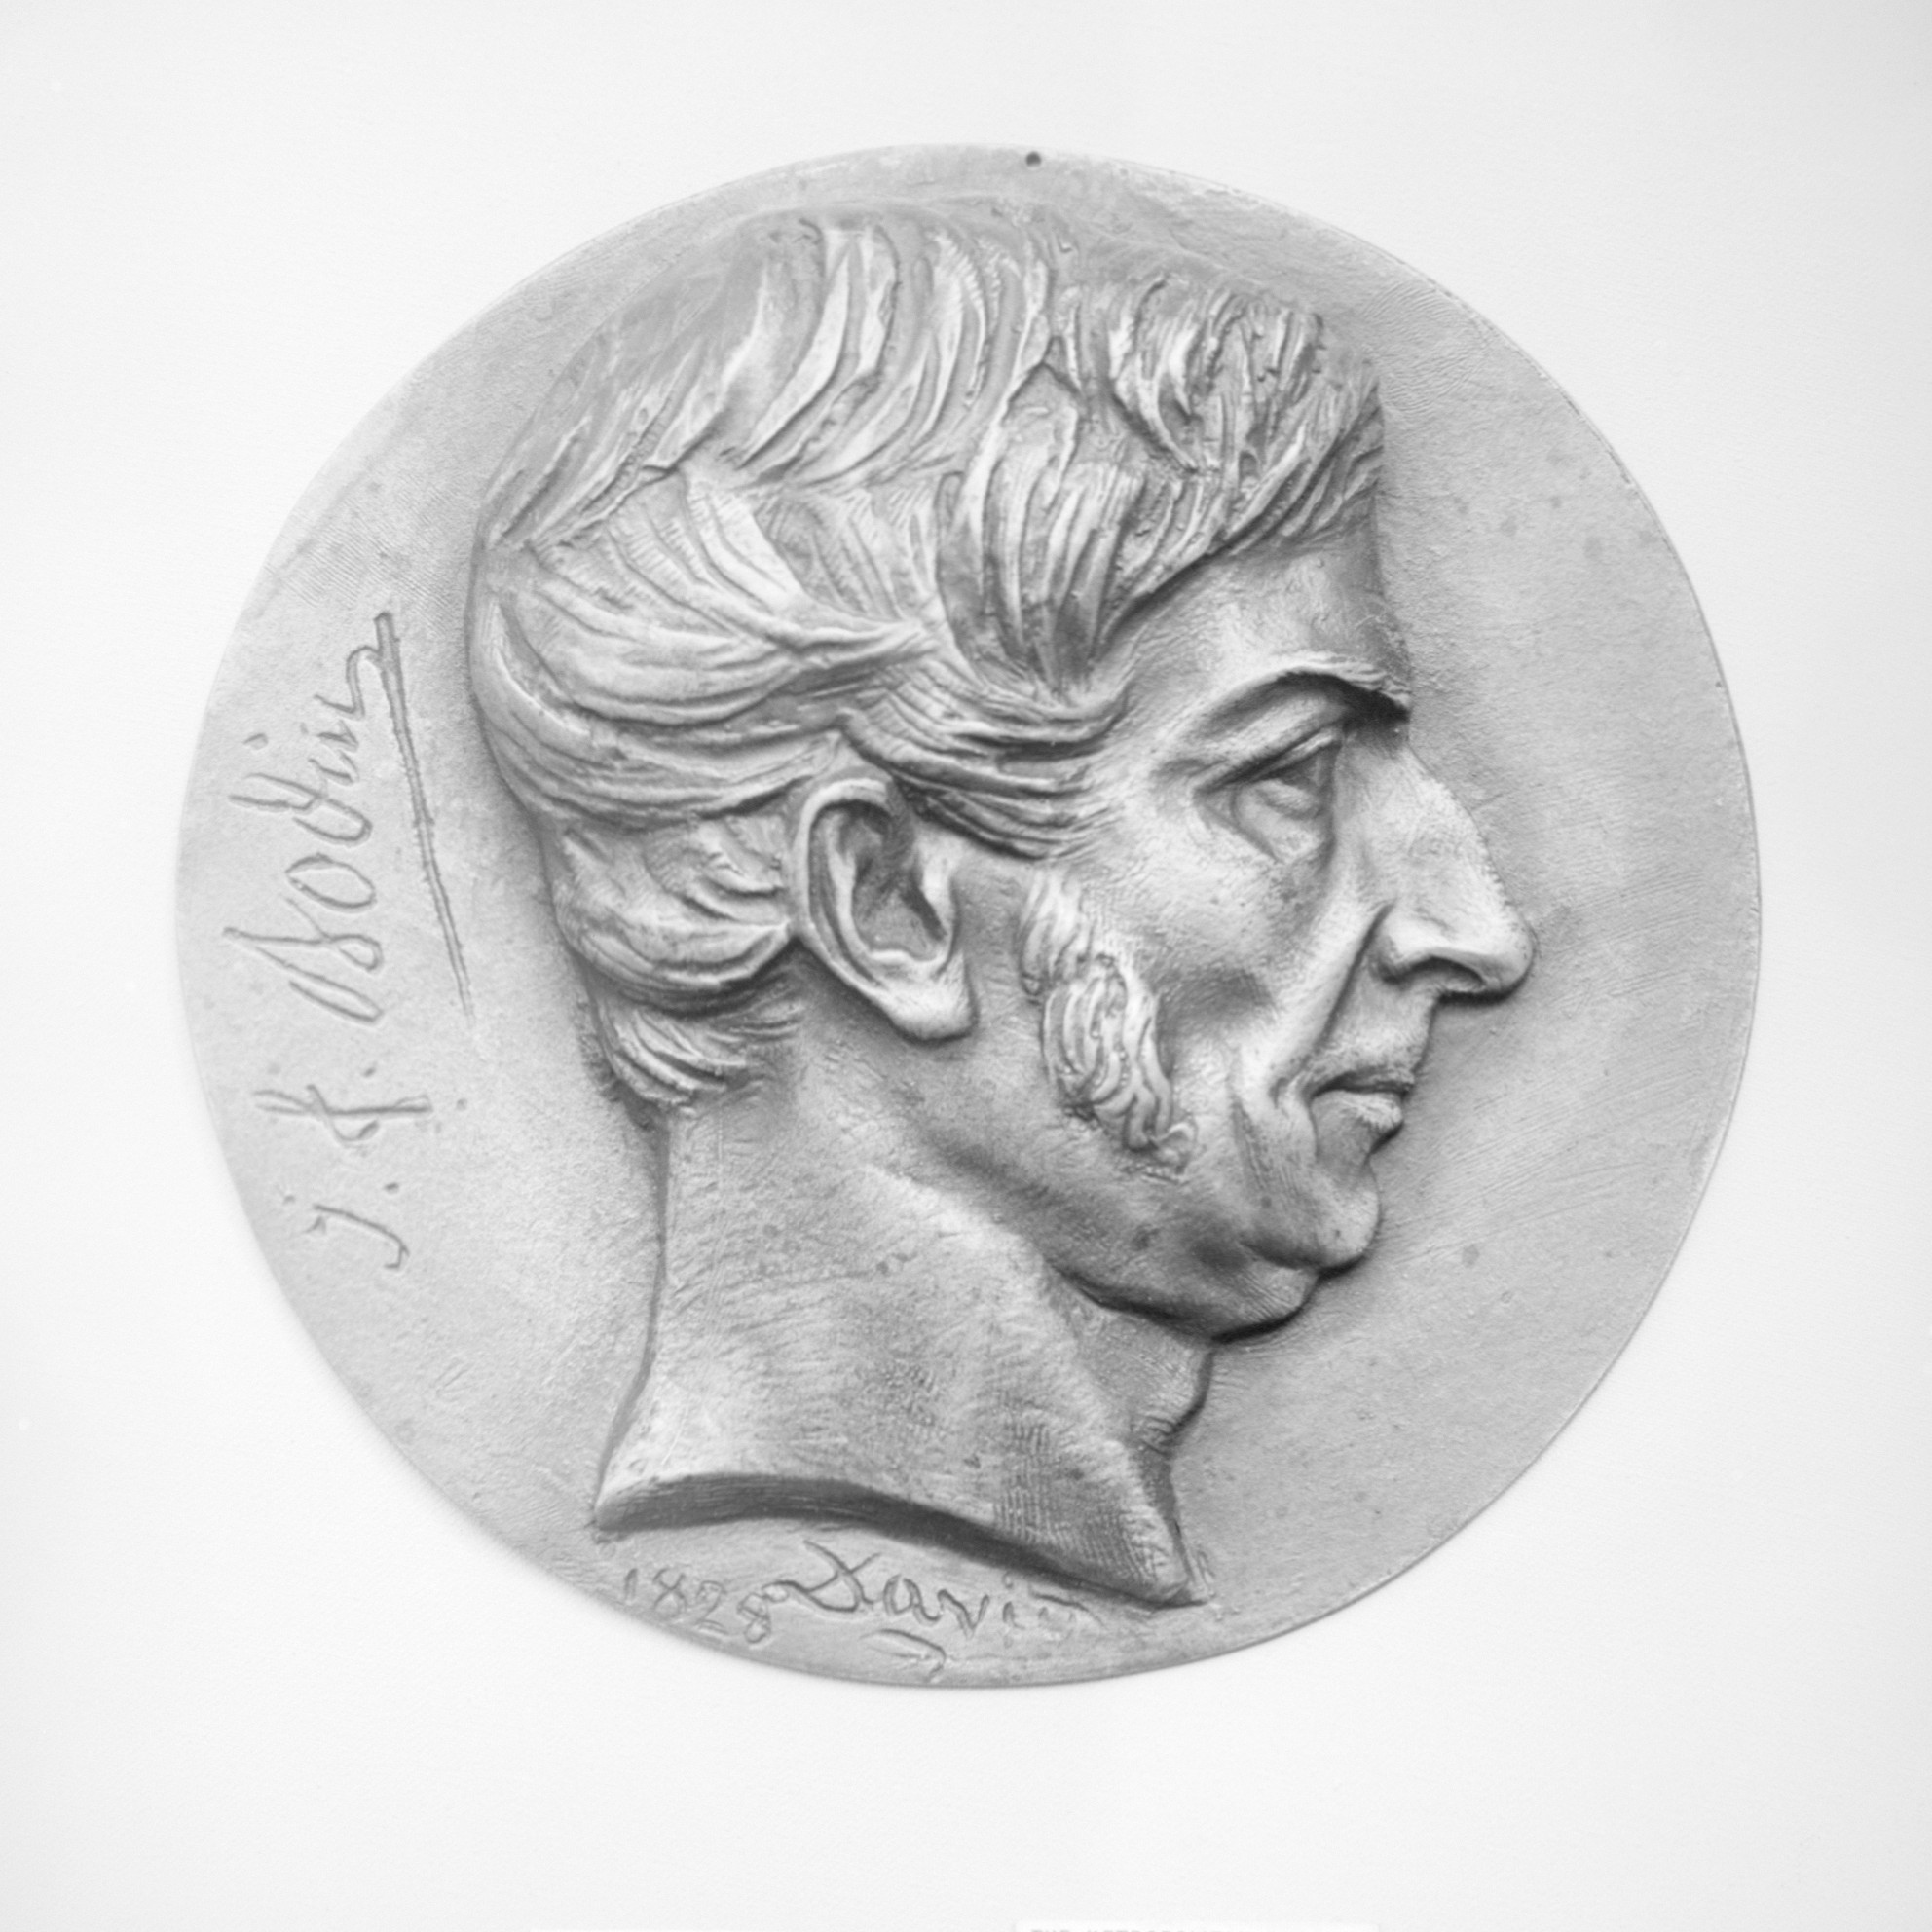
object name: medallion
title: Jean François Bodin (1776–1829), French civil-servant and historian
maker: pierre jean david d'angers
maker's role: artist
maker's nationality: french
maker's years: 1788-1856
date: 1828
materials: bronze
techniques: casting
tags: men,profiles